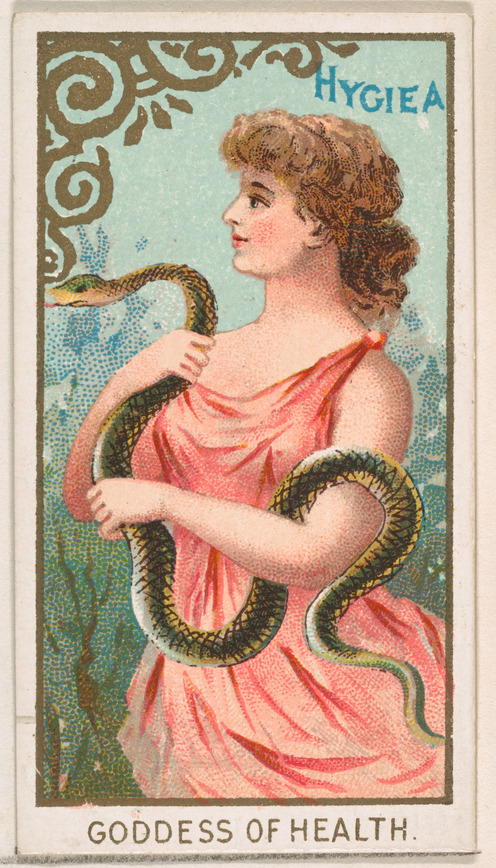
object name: print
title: Hygiea, Goddess of Health, from the Goddesses of the Greeks and Romans series (N188) issued by Wm. S. Kimball & Co.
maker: william s. kimball & company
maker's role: publisher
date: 1889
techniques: color lithograph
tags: snakes,goddess